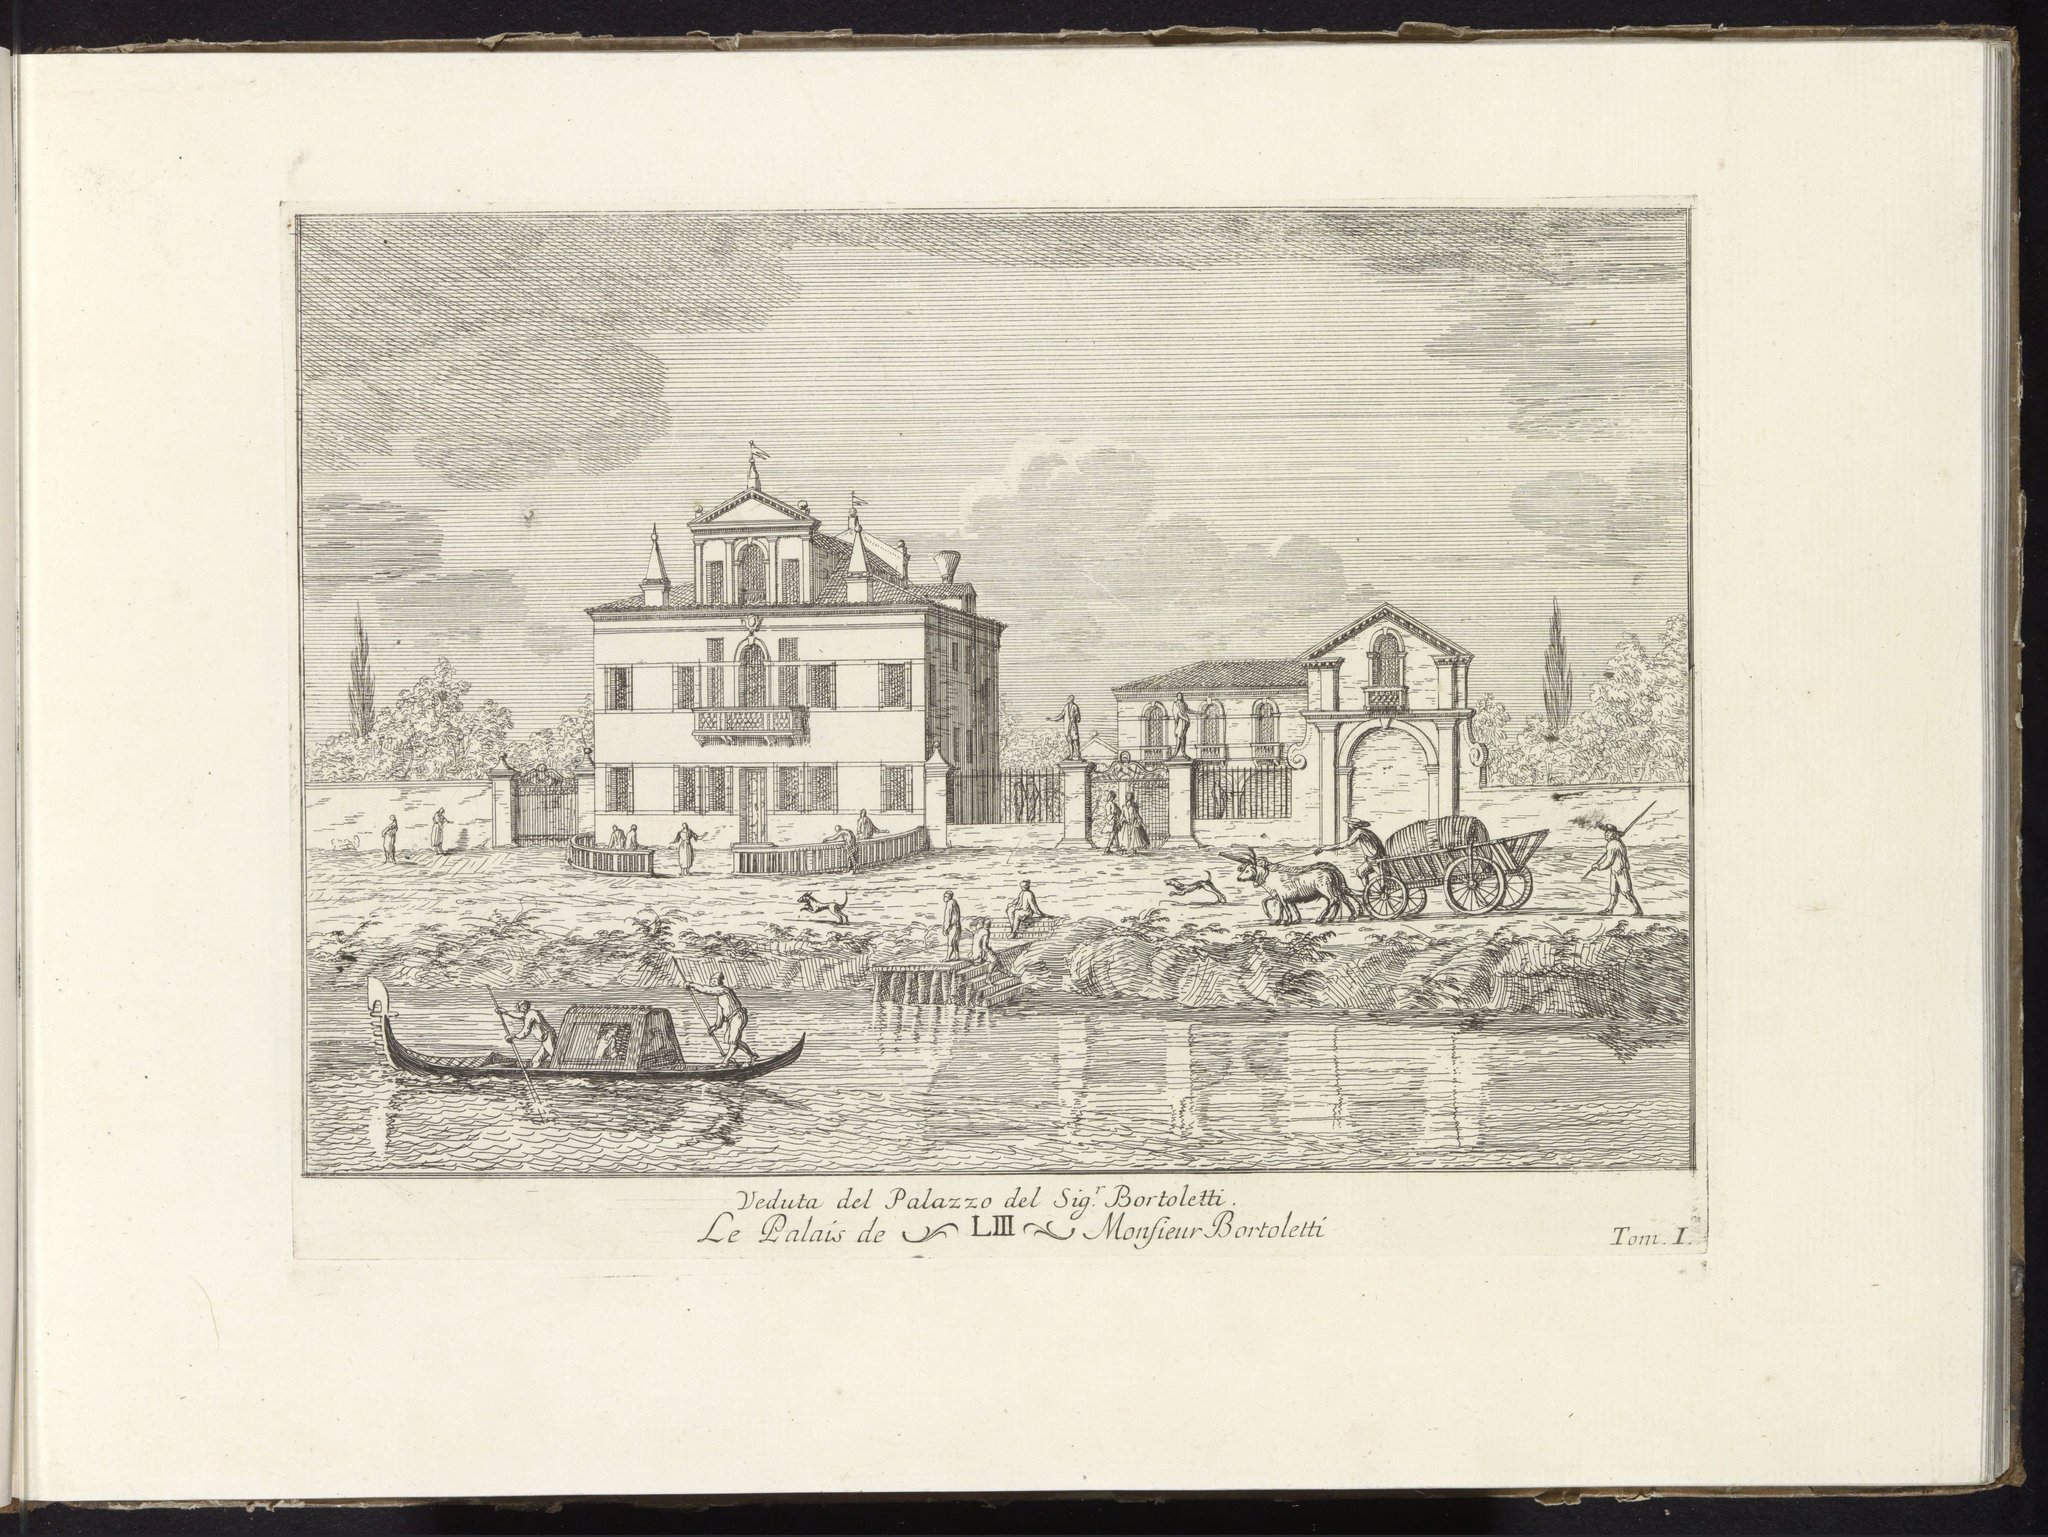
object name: print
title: Les delices de la Brenta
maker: giovanni francesco costa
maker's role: draughtsman, painter, print maker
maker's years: -1773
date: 1750-1760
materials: paper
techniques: etching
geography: venice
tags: river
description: Gezicht op Palazzo del Signore Bortoletti aan de rivier de Brenta. Genummerd midden onder: LIII en rechtsonder: Tom: I. Deze prent maakt deel uit van een album.